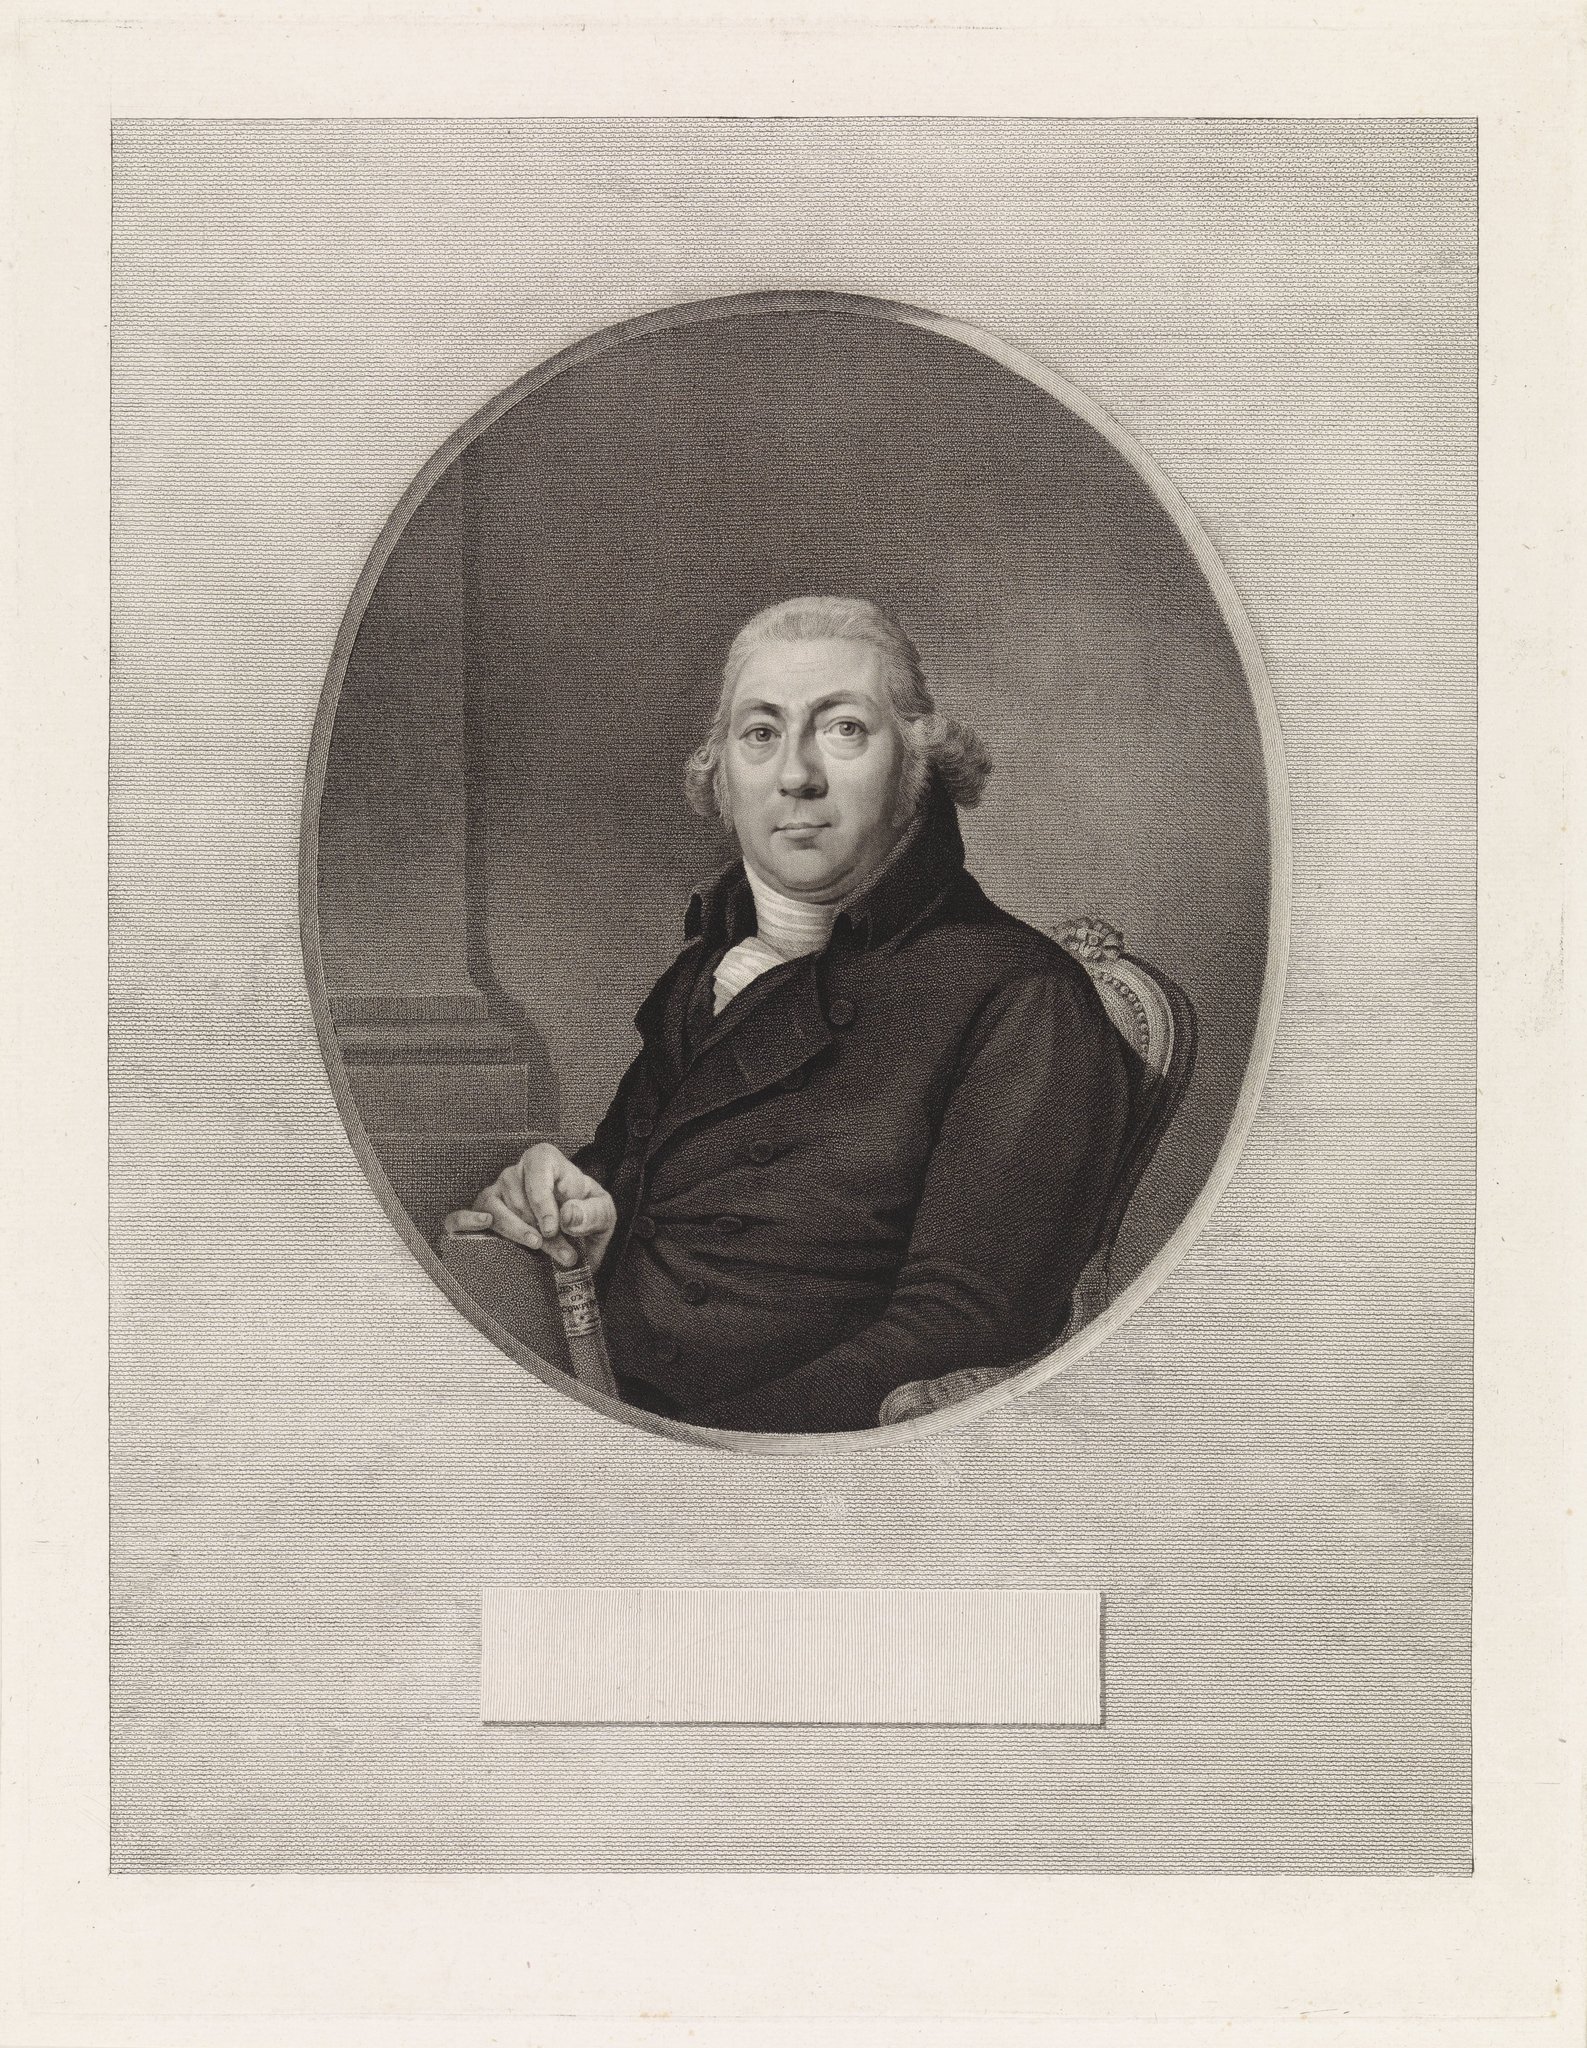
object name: print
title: Portret van Phoebus Hitzerus Themmen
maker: ludwig gottlieb portman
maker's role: print maker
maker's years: 1772-1828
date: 1794-1828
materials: paper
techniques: engraving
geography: amsterdam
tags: amsterdam, phoebus hitzerus themmen, book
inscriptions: collector's mark: Lugt 2228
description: Portret van de schrijver Phoebus Hitzerus Themmen. In zijn hand houdt hij het boek Further Observations on the Variolæ Vaccinæ, or Cow-Pox (1799) van Edward Anthony Jenner.